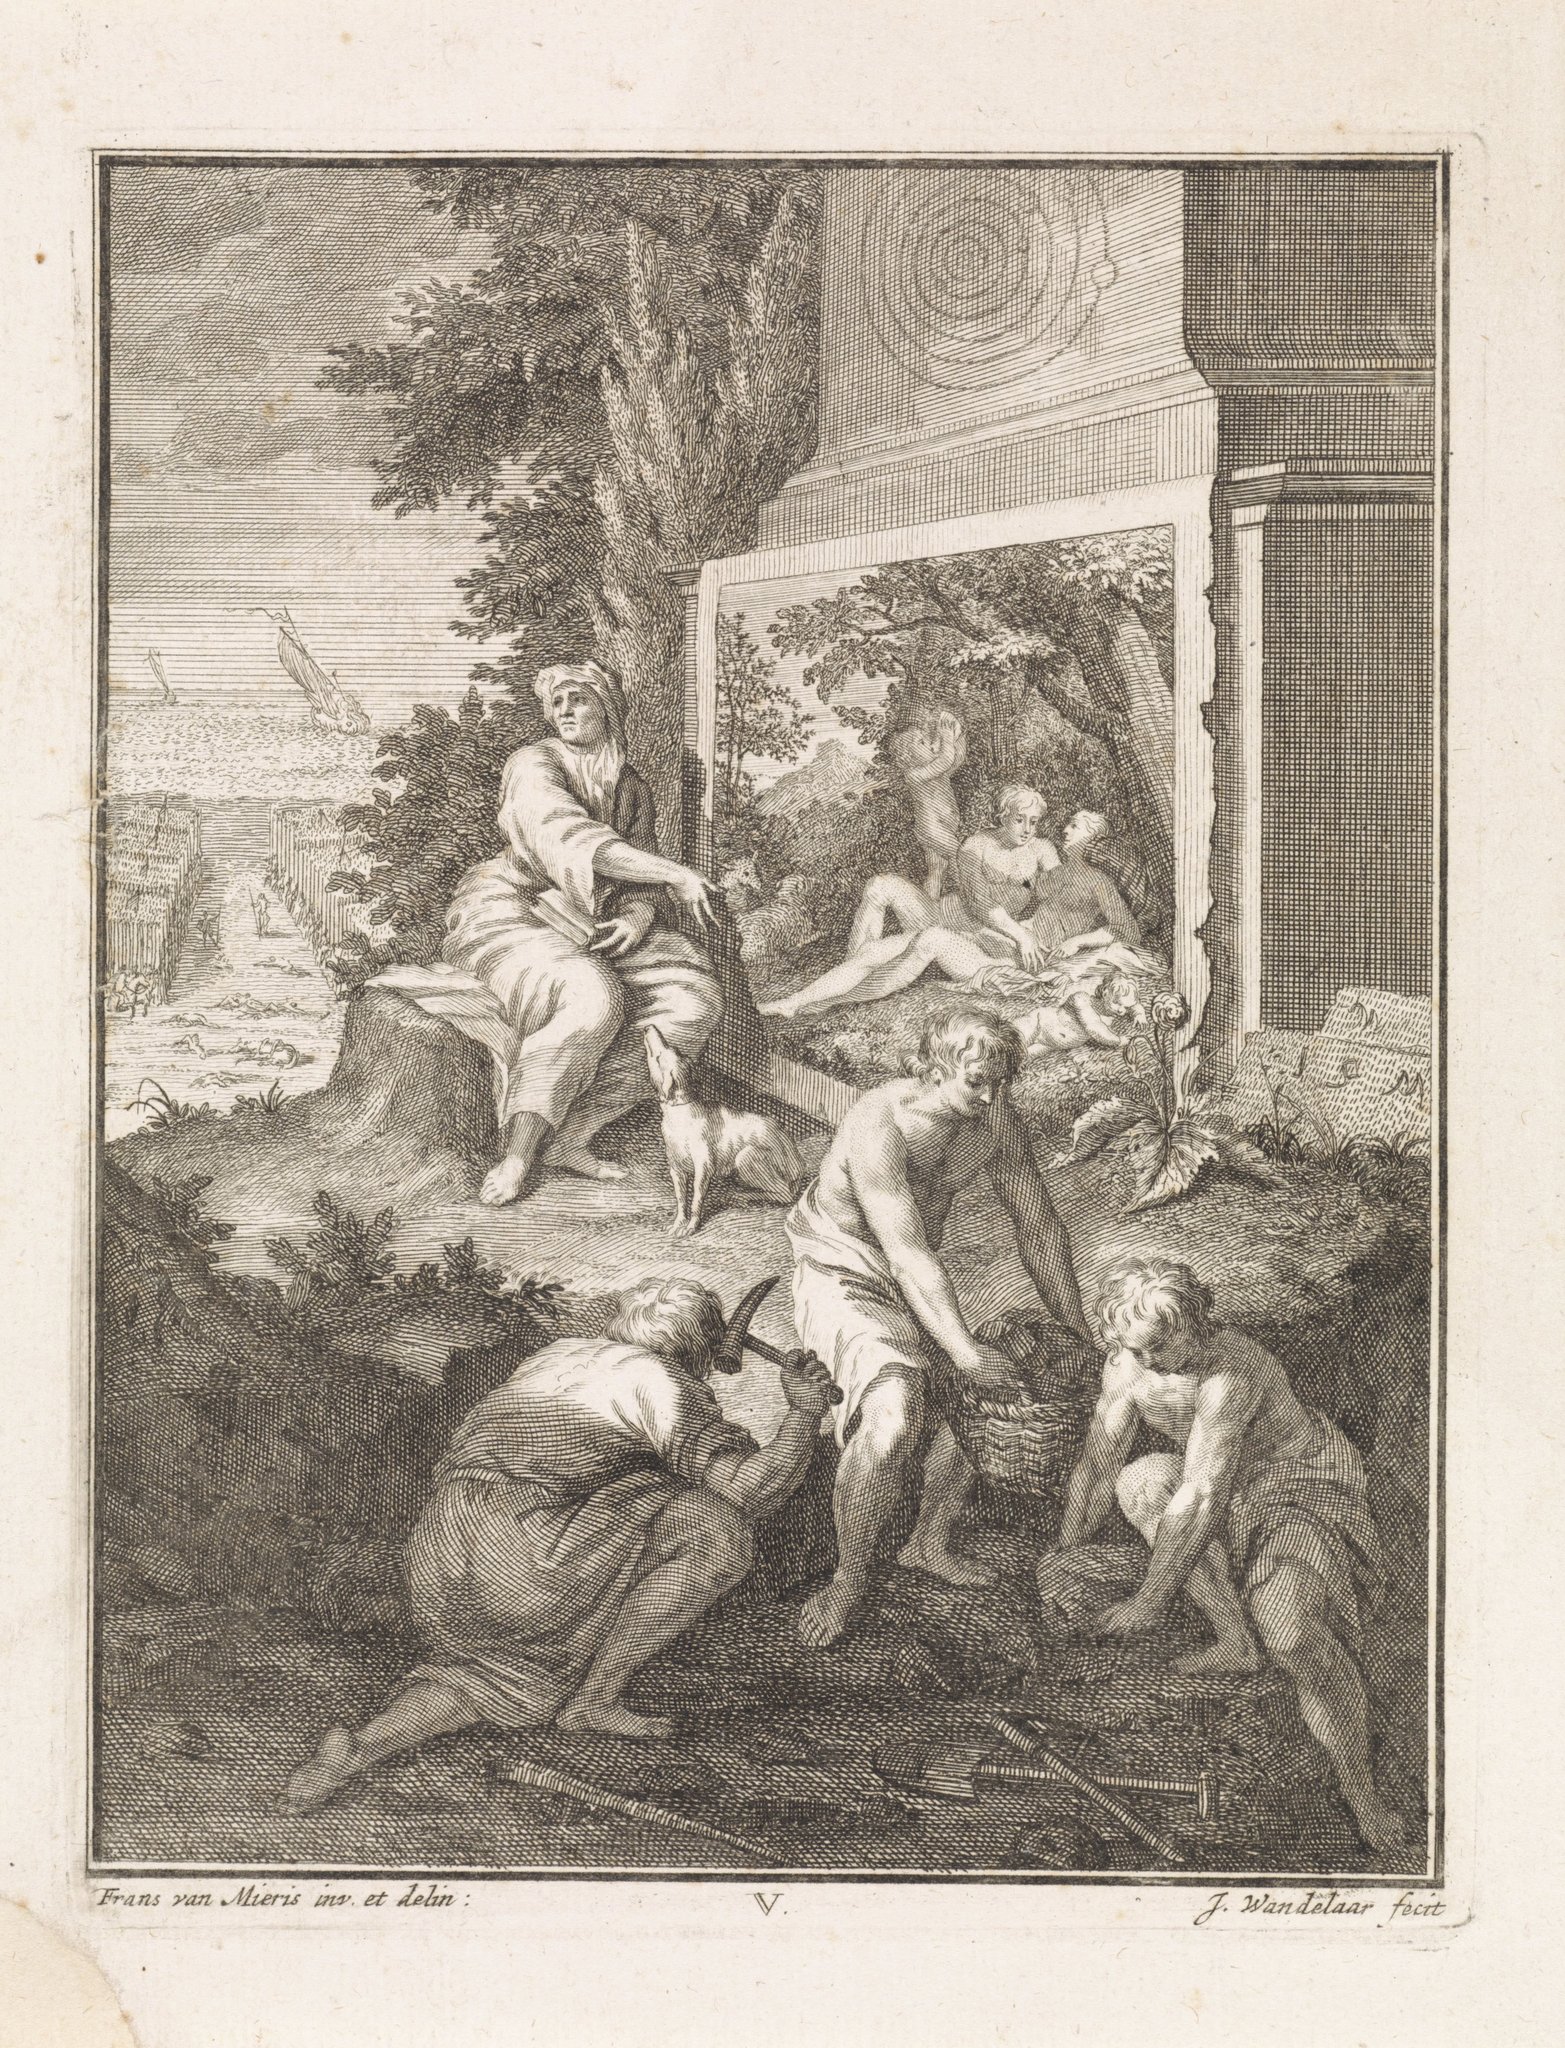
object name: book illustration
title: Landschap met een oude vrouw bij een monument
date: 1725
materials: paper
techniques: engraving, etching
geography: northern netherlands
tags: finding a dead person, tools, aids, implements ~ crafts and industries: hammer, (lovers) caressing each other, sundial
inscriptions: collector's mark: Lugt 240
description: Een oude vrouw in een landschap zit bij een monument waarop een verliefd paar, dat naakt in het bos ligt, met twee kinderen is afgebeeld, en daarboven een zonnewijzer. Op de voorgrond zijn drie mannen aan het werk, rond hen ligt gereedschap verspreid. Op de achtergrond een akker met dode lichamen. Genummerd midden onder: V.